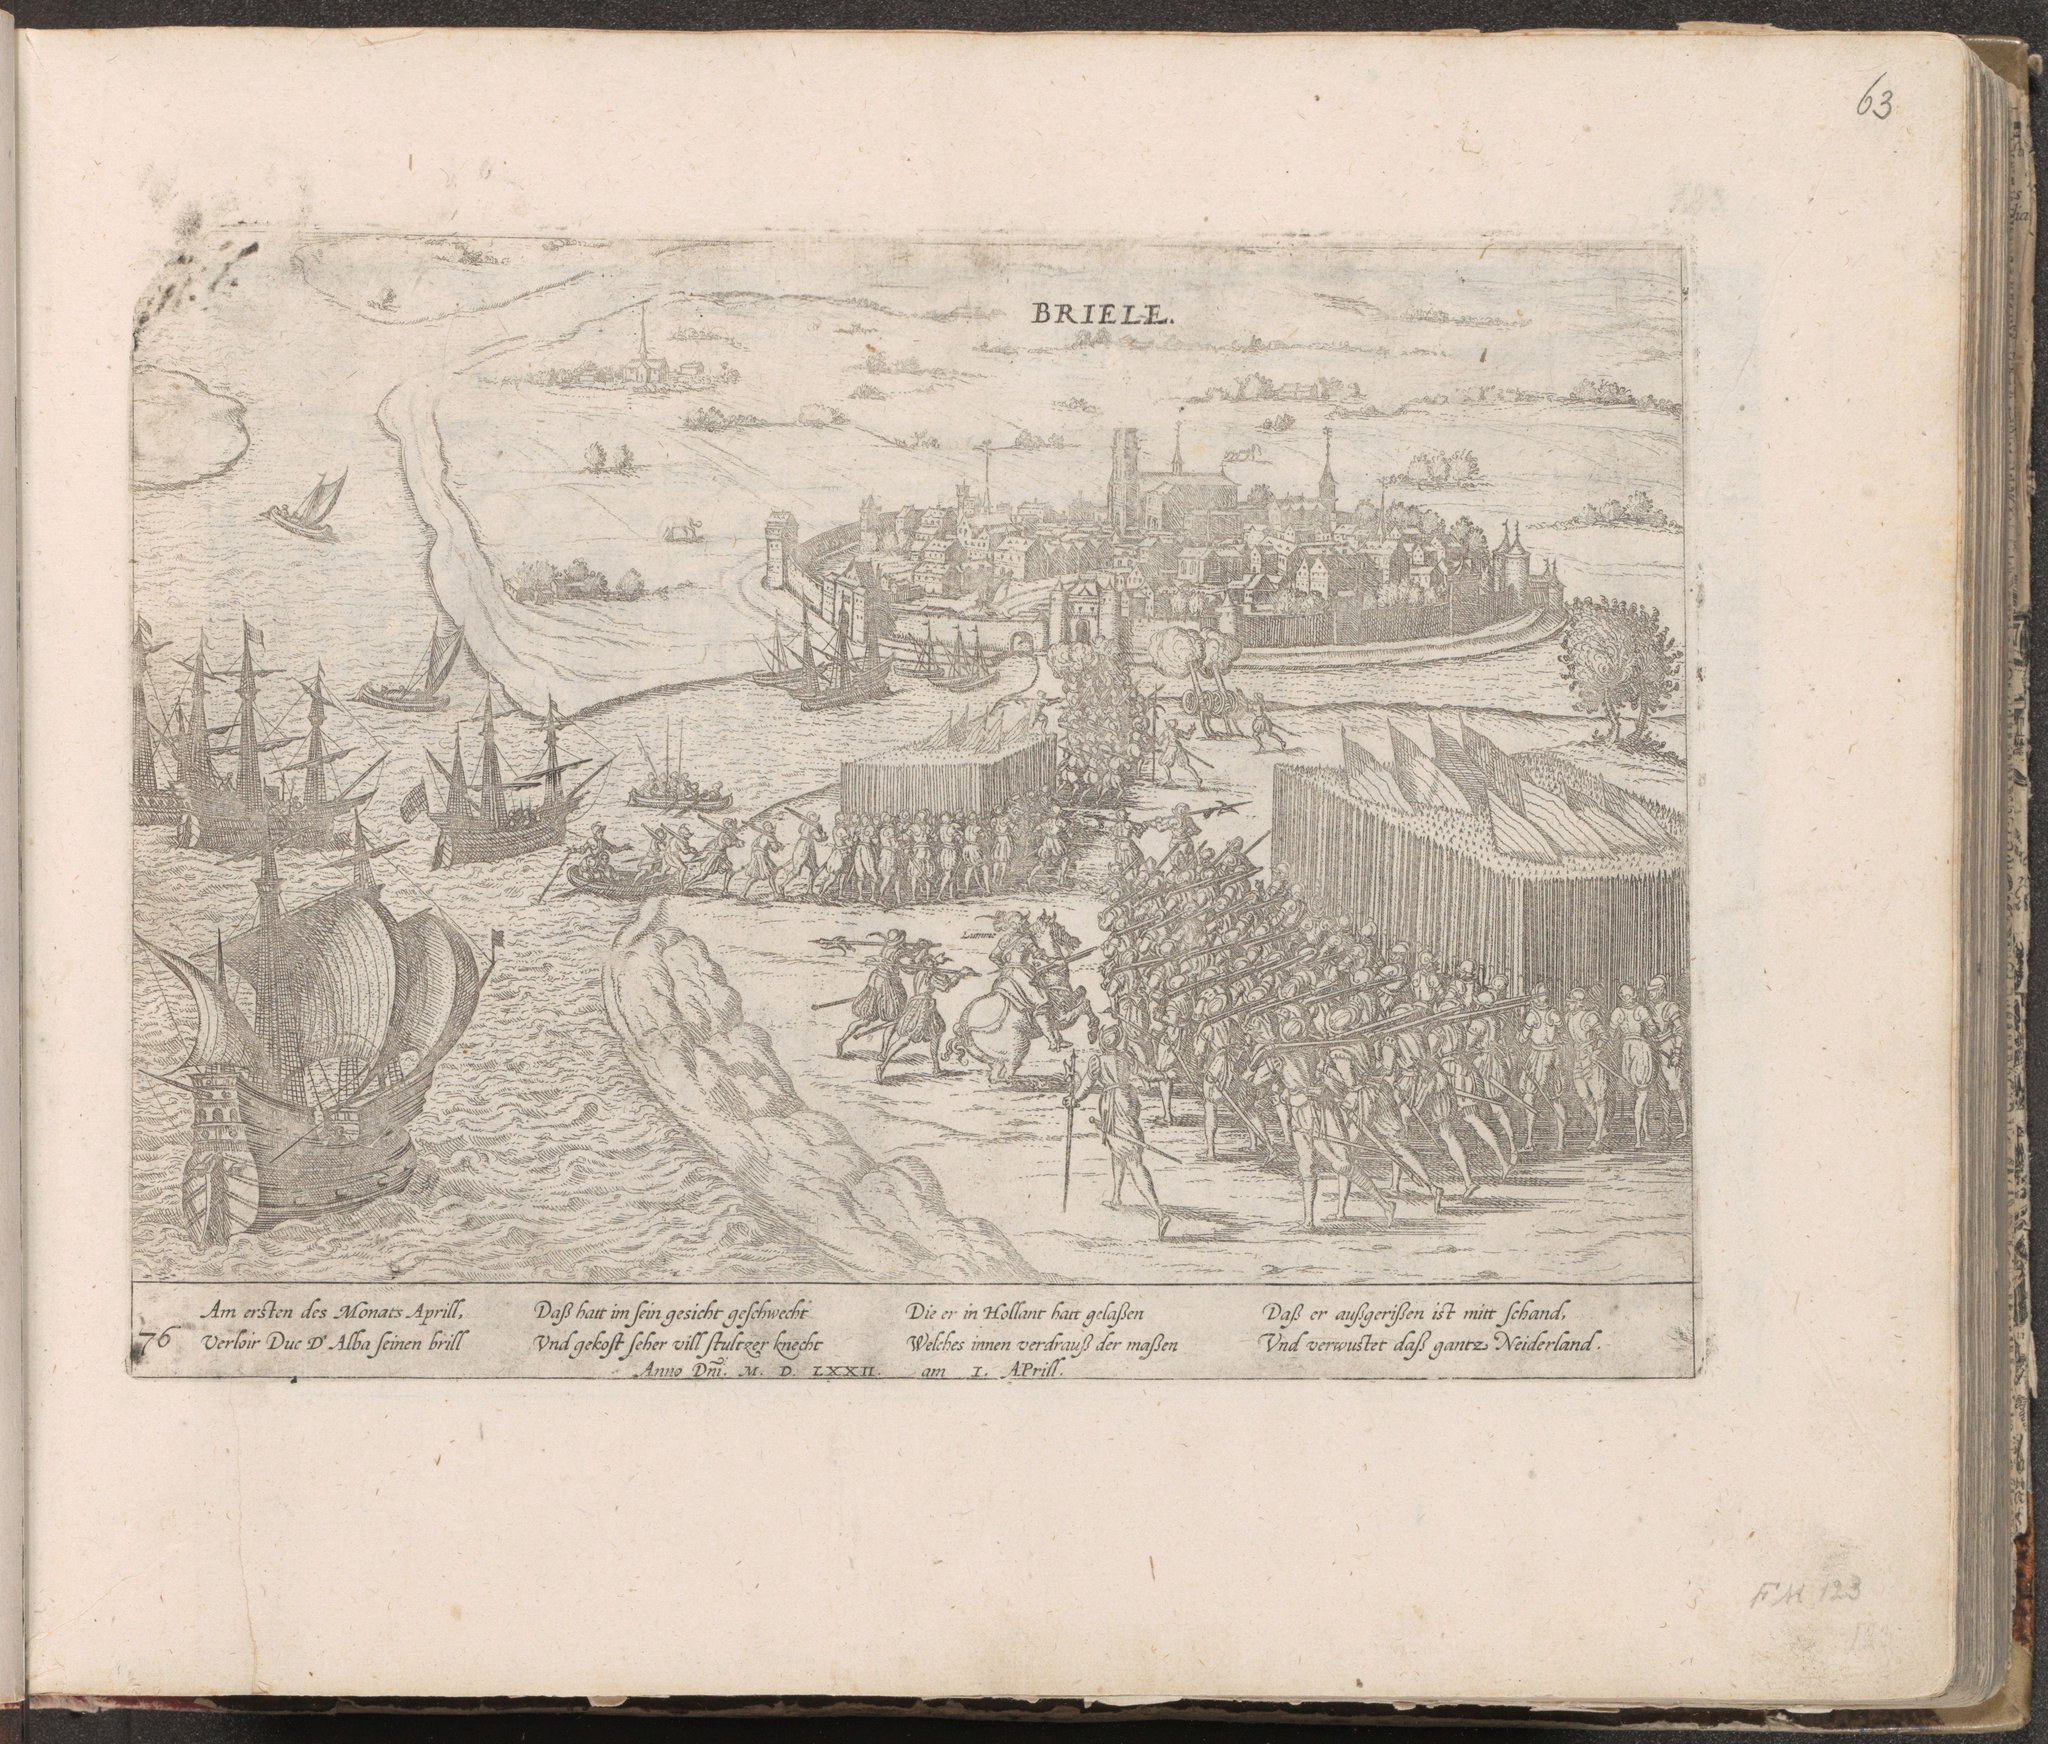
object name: album leaf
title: Serie 6: Nederlandse Gebeurtenissen, 1571-1576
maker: frans hogenberg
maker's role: print maker, publisher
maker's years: 1538-1590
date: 1574-1578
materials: paper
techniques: etching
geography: cologne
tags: capture of city (after the siege), brielle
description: Watergeuzen nemen Den Briel in, 1 april 1572. De watergeuzen komen aan land, trekken op en veroveren onder leiding van Lumey Den Briel. Met onderschrift van 8 regels in het Duits. Linksonder genummerd: 76. De prent maakt deel uit van een album.